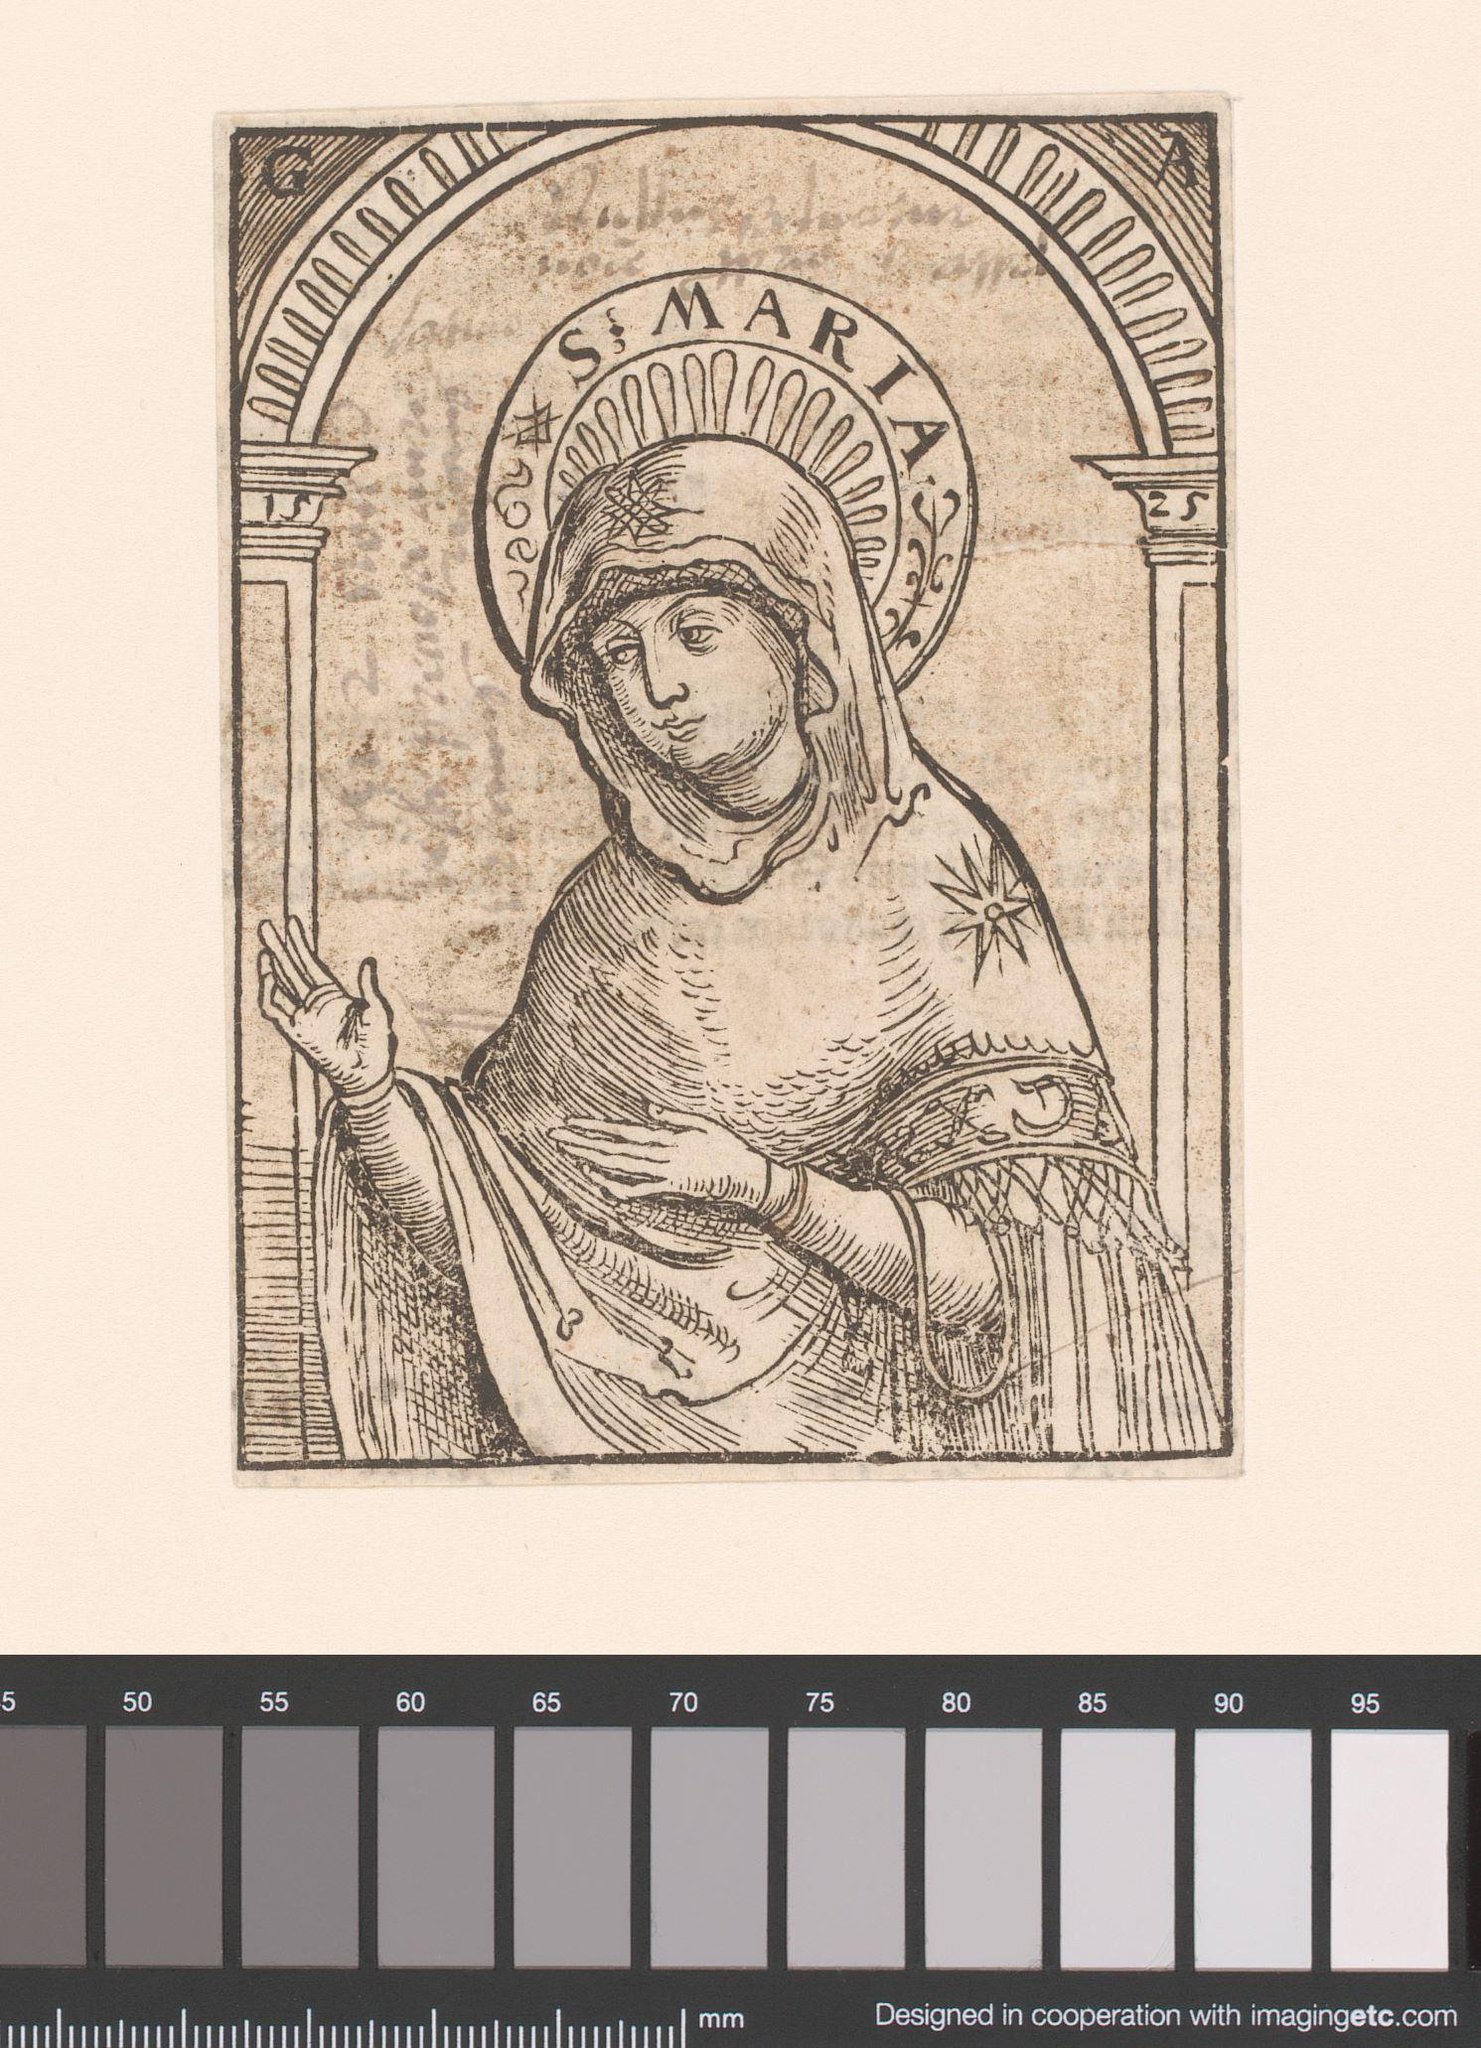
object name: book illustration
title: Maria onder een boog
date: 1525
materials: paper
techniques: woodcut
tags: the virgin mary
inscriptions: collector's mark: Lugt 2228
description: Prent afkomstig uit: Eck, Johannes. Enchiridion locorum (...). Krakau: Hieronymus Vietor, 1525.